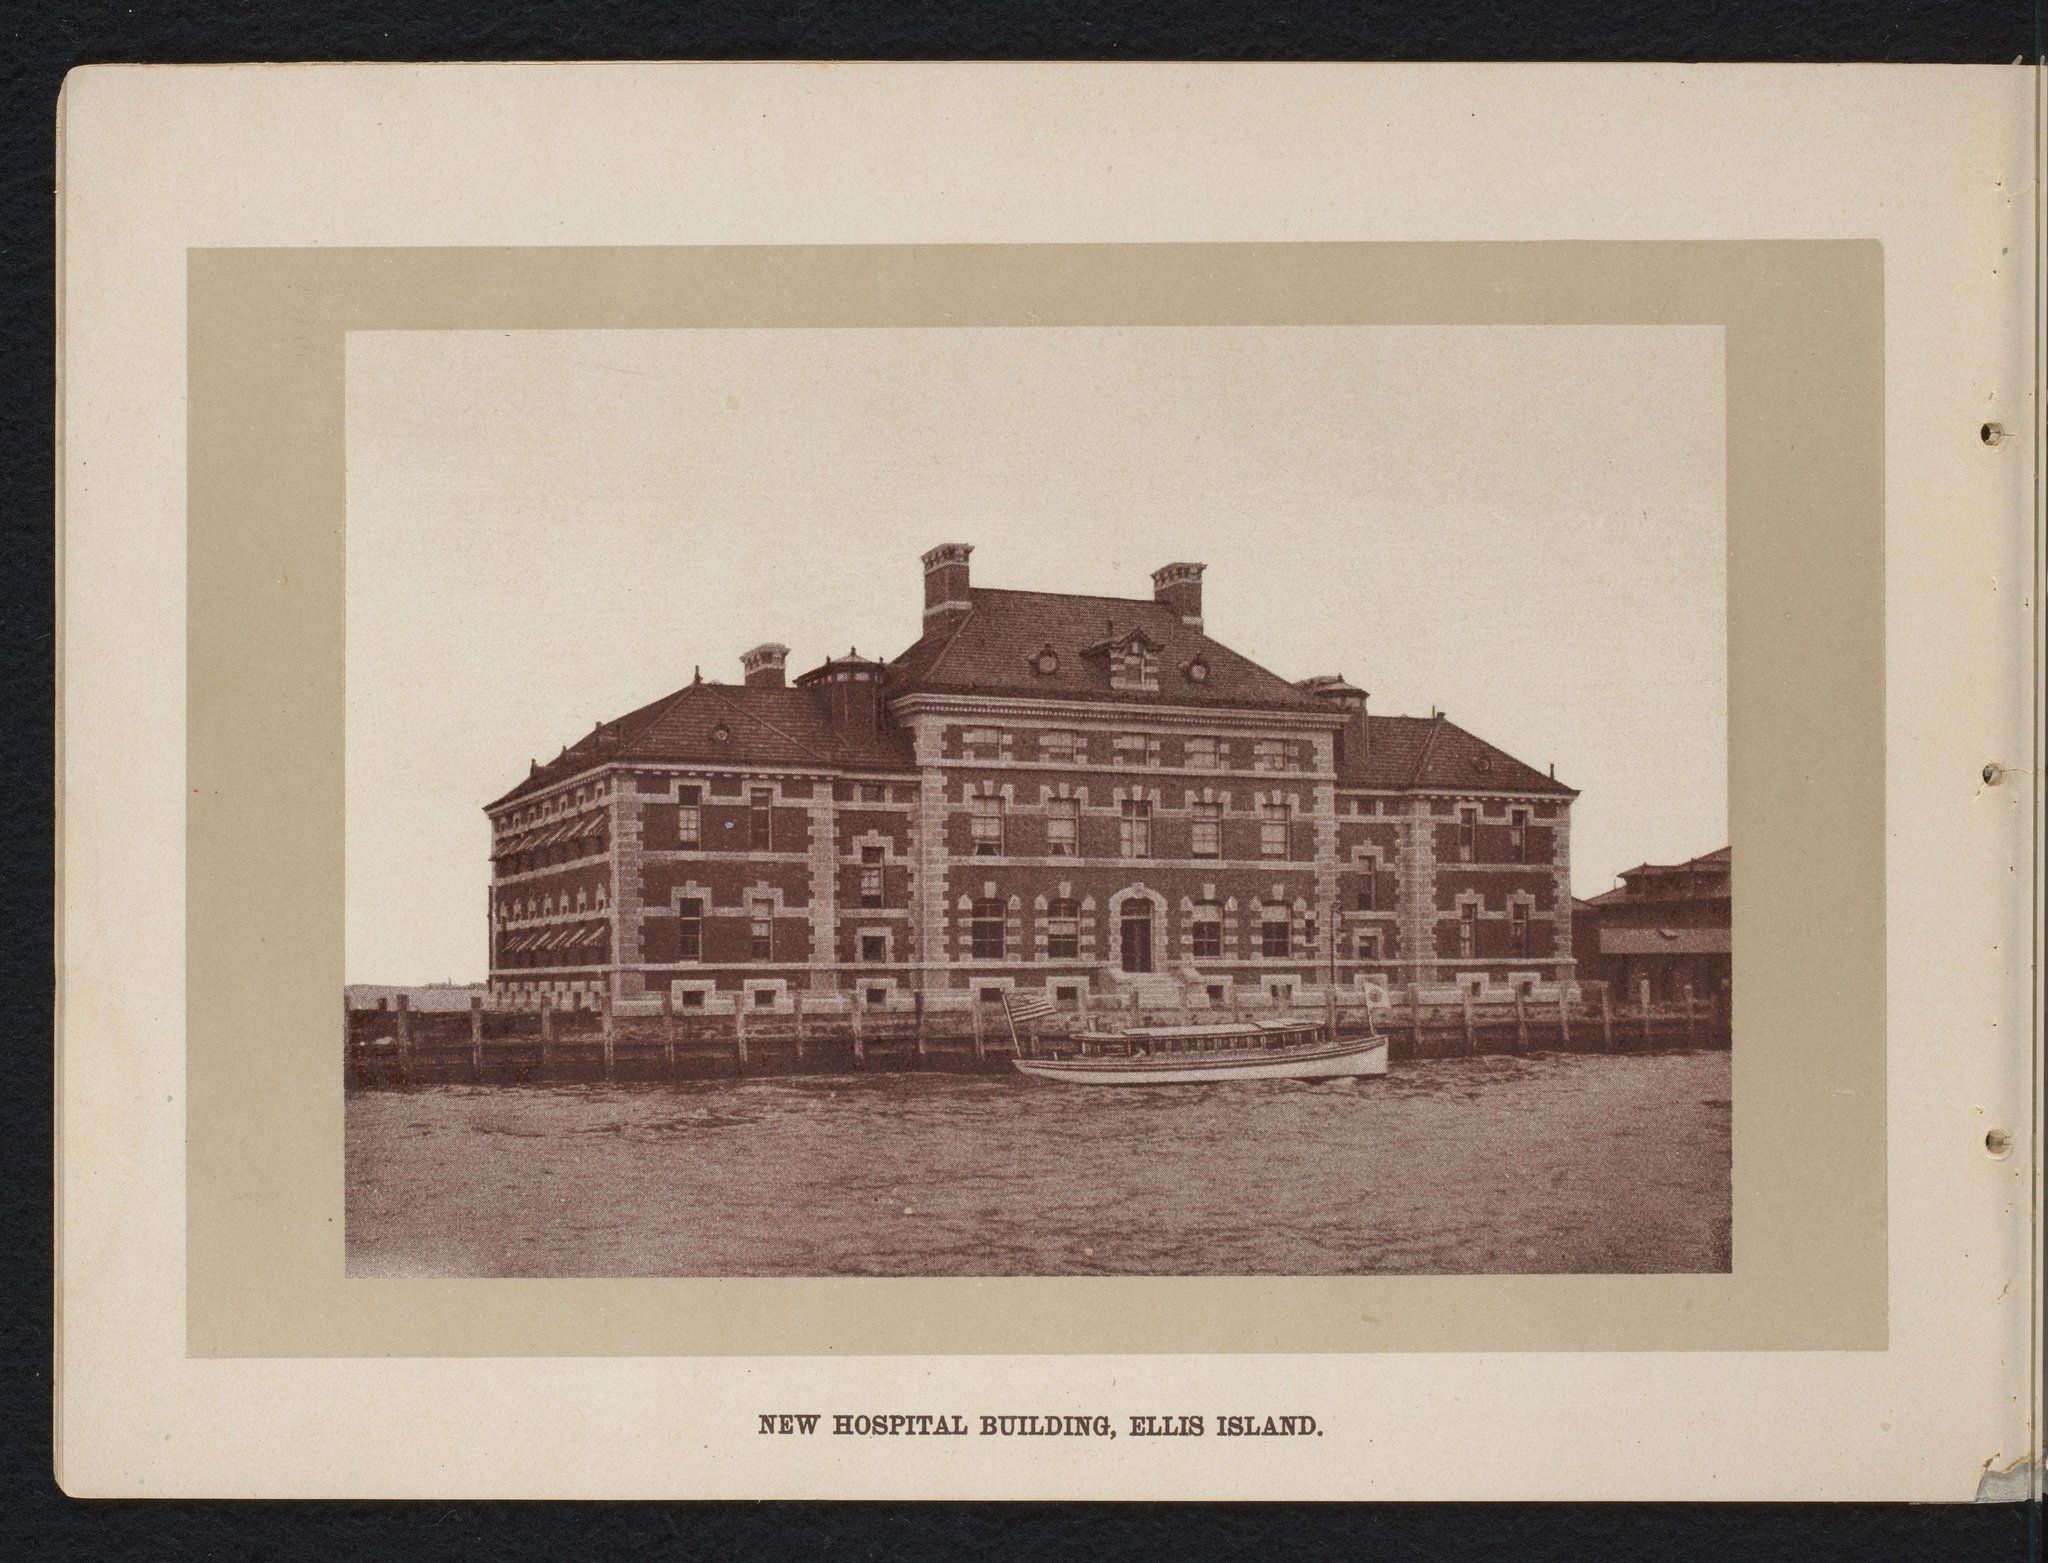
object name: photomechanical print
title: Gezicht op het nieuwe ziekenhuis op Ellis Island, New York, bestemd voor migranten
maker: Anonymous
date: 1897-1902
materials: paper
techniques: autotype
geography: new york city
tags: (descendants of) european emigrants to america, hospital, diseases